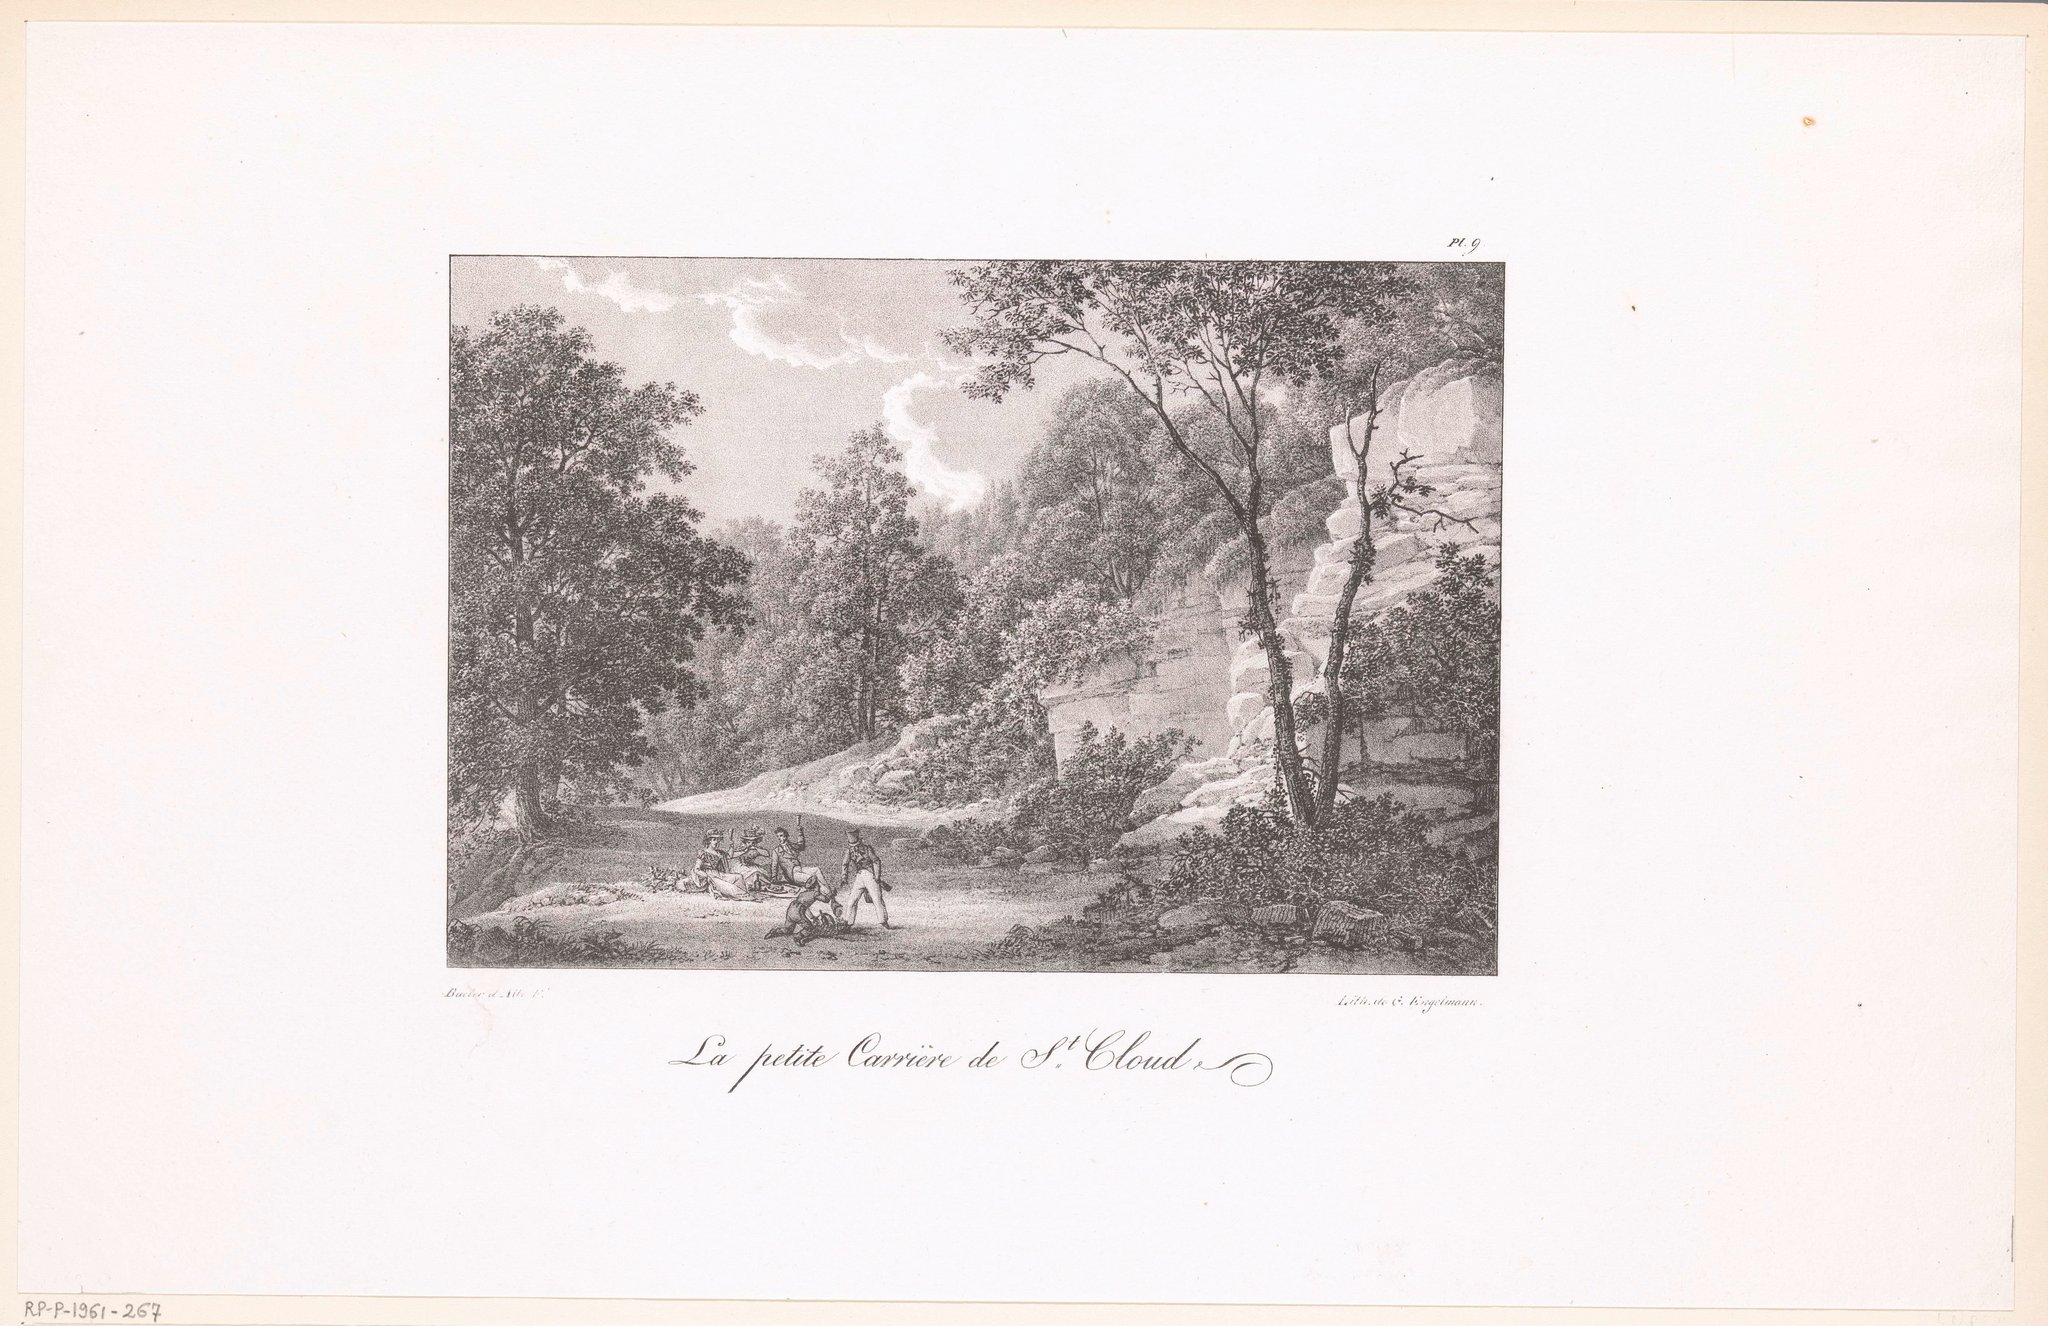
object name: print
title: Pittoreske gezichten op Parijs en omgeving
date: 1822-1824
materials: paper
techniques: lithograph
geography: paris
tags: picnic, alfresco, 'déjeuner sur l'herbe', outdoor gathering, 'délices à la campagne'